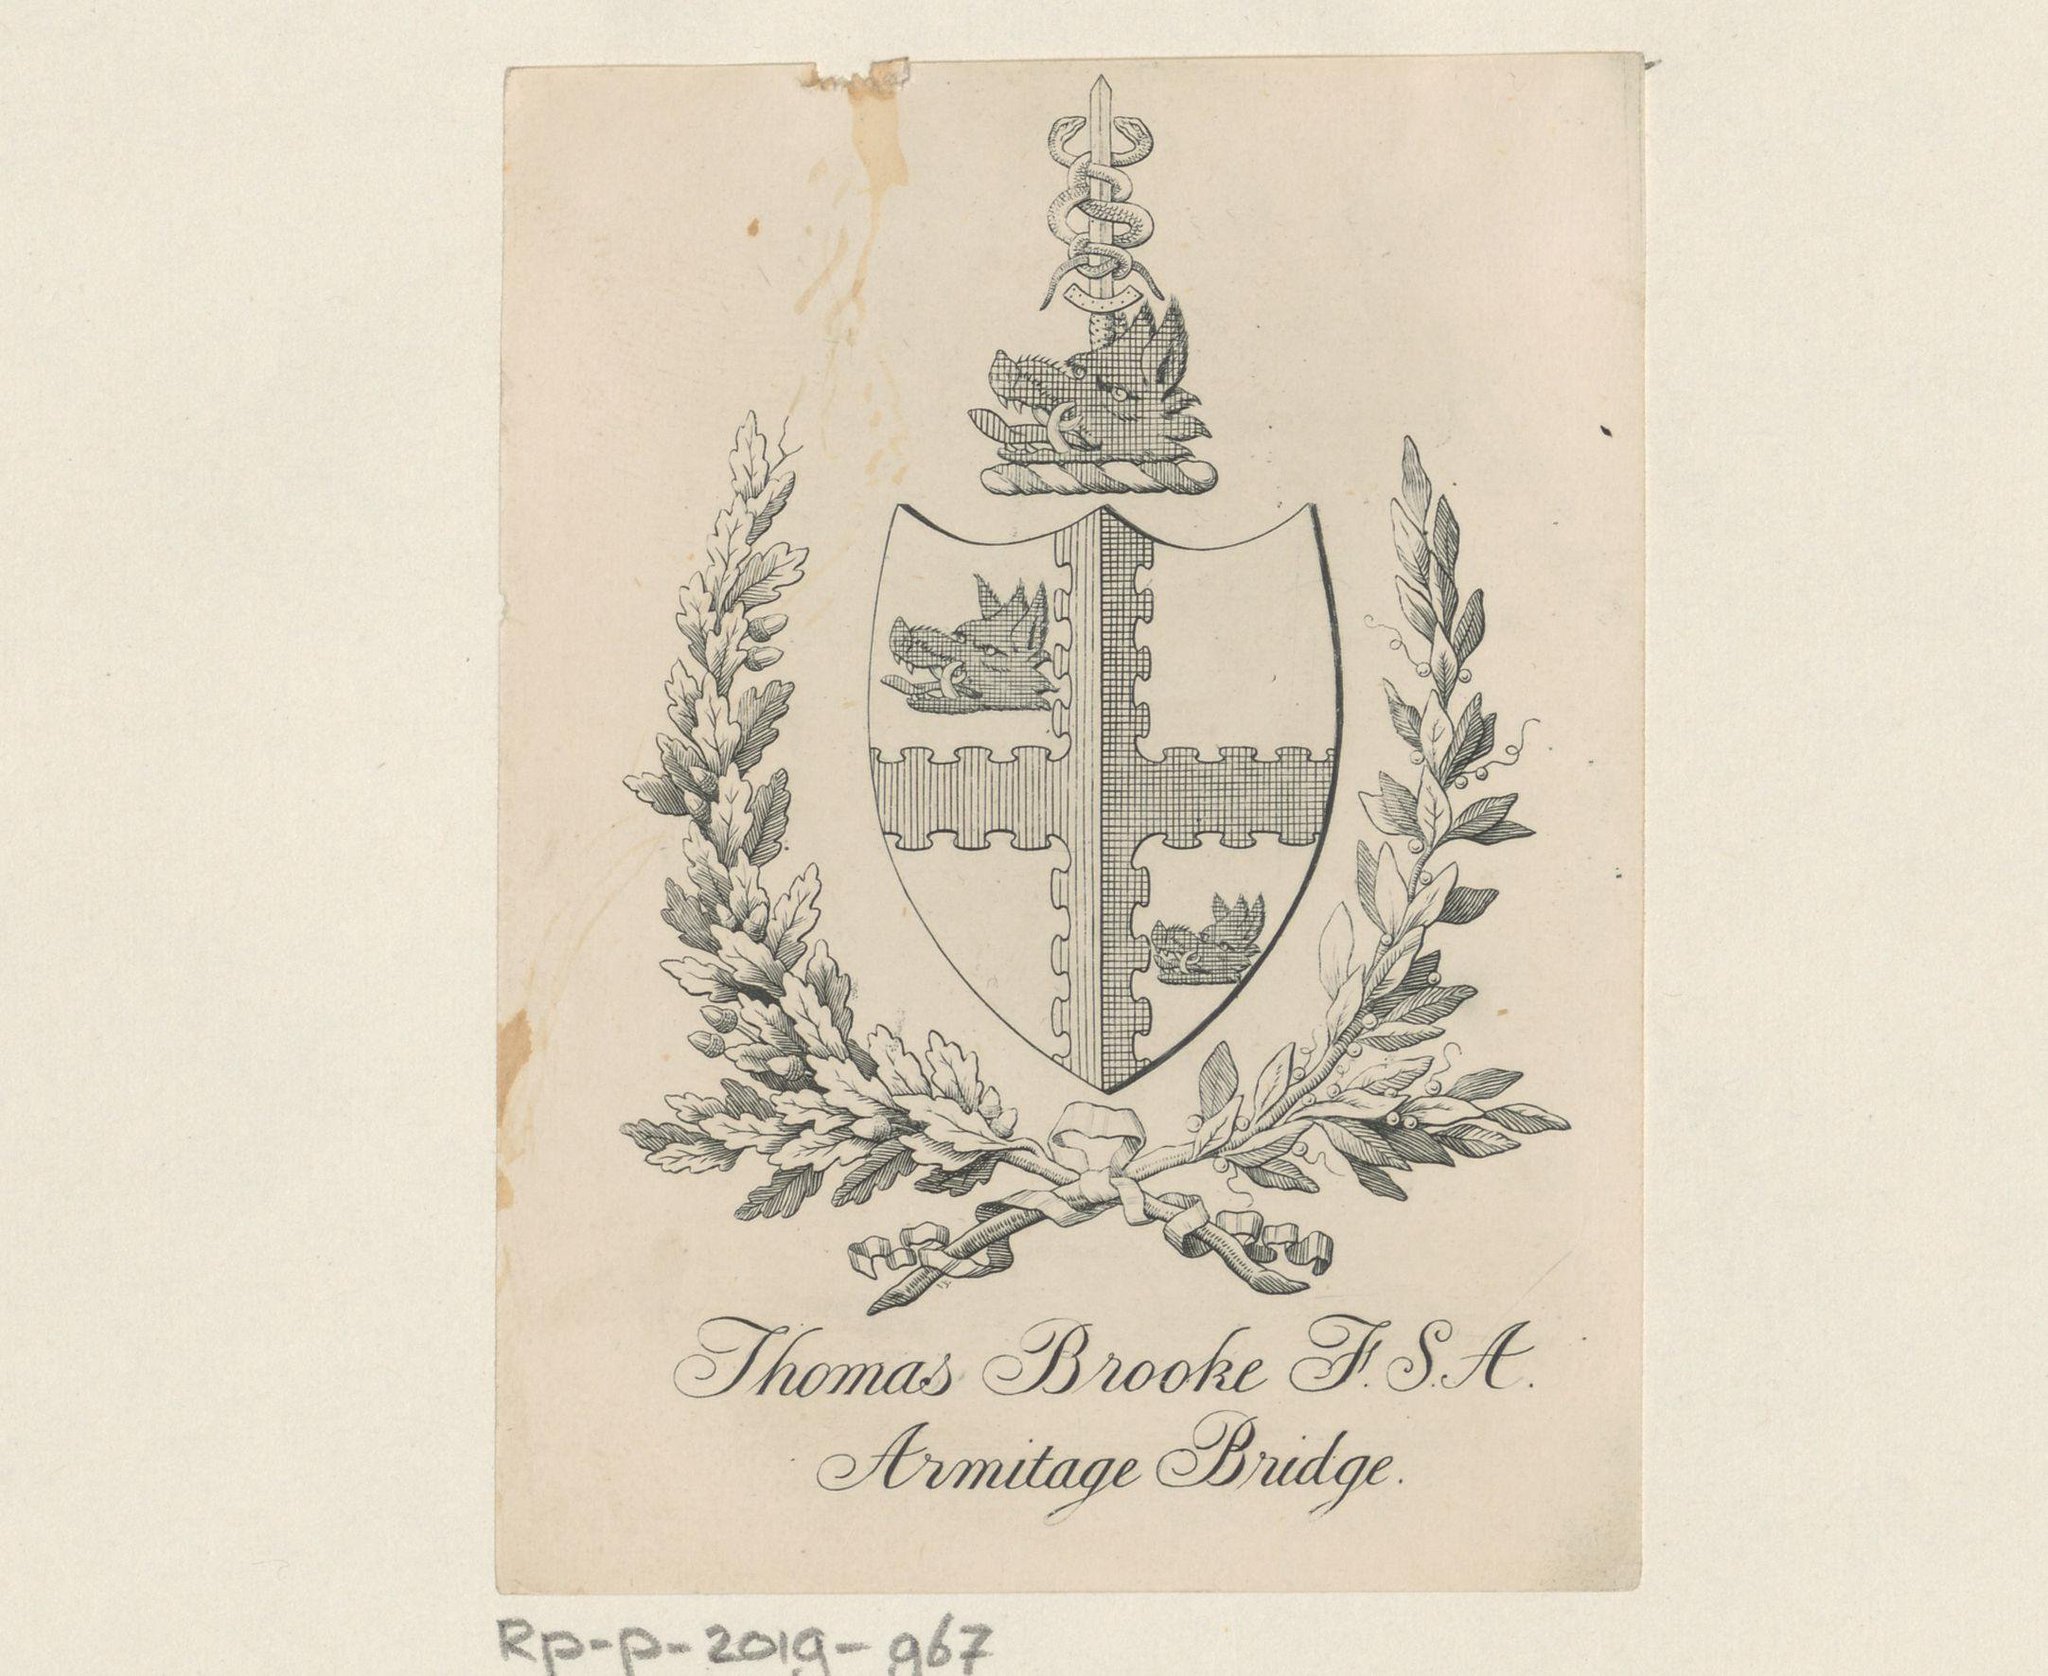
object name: bookplate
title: Ex libris van Thomas Brooke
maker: Anonymous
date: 1800-1899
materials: paper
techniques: engraving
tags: armorial bearing, heraldry